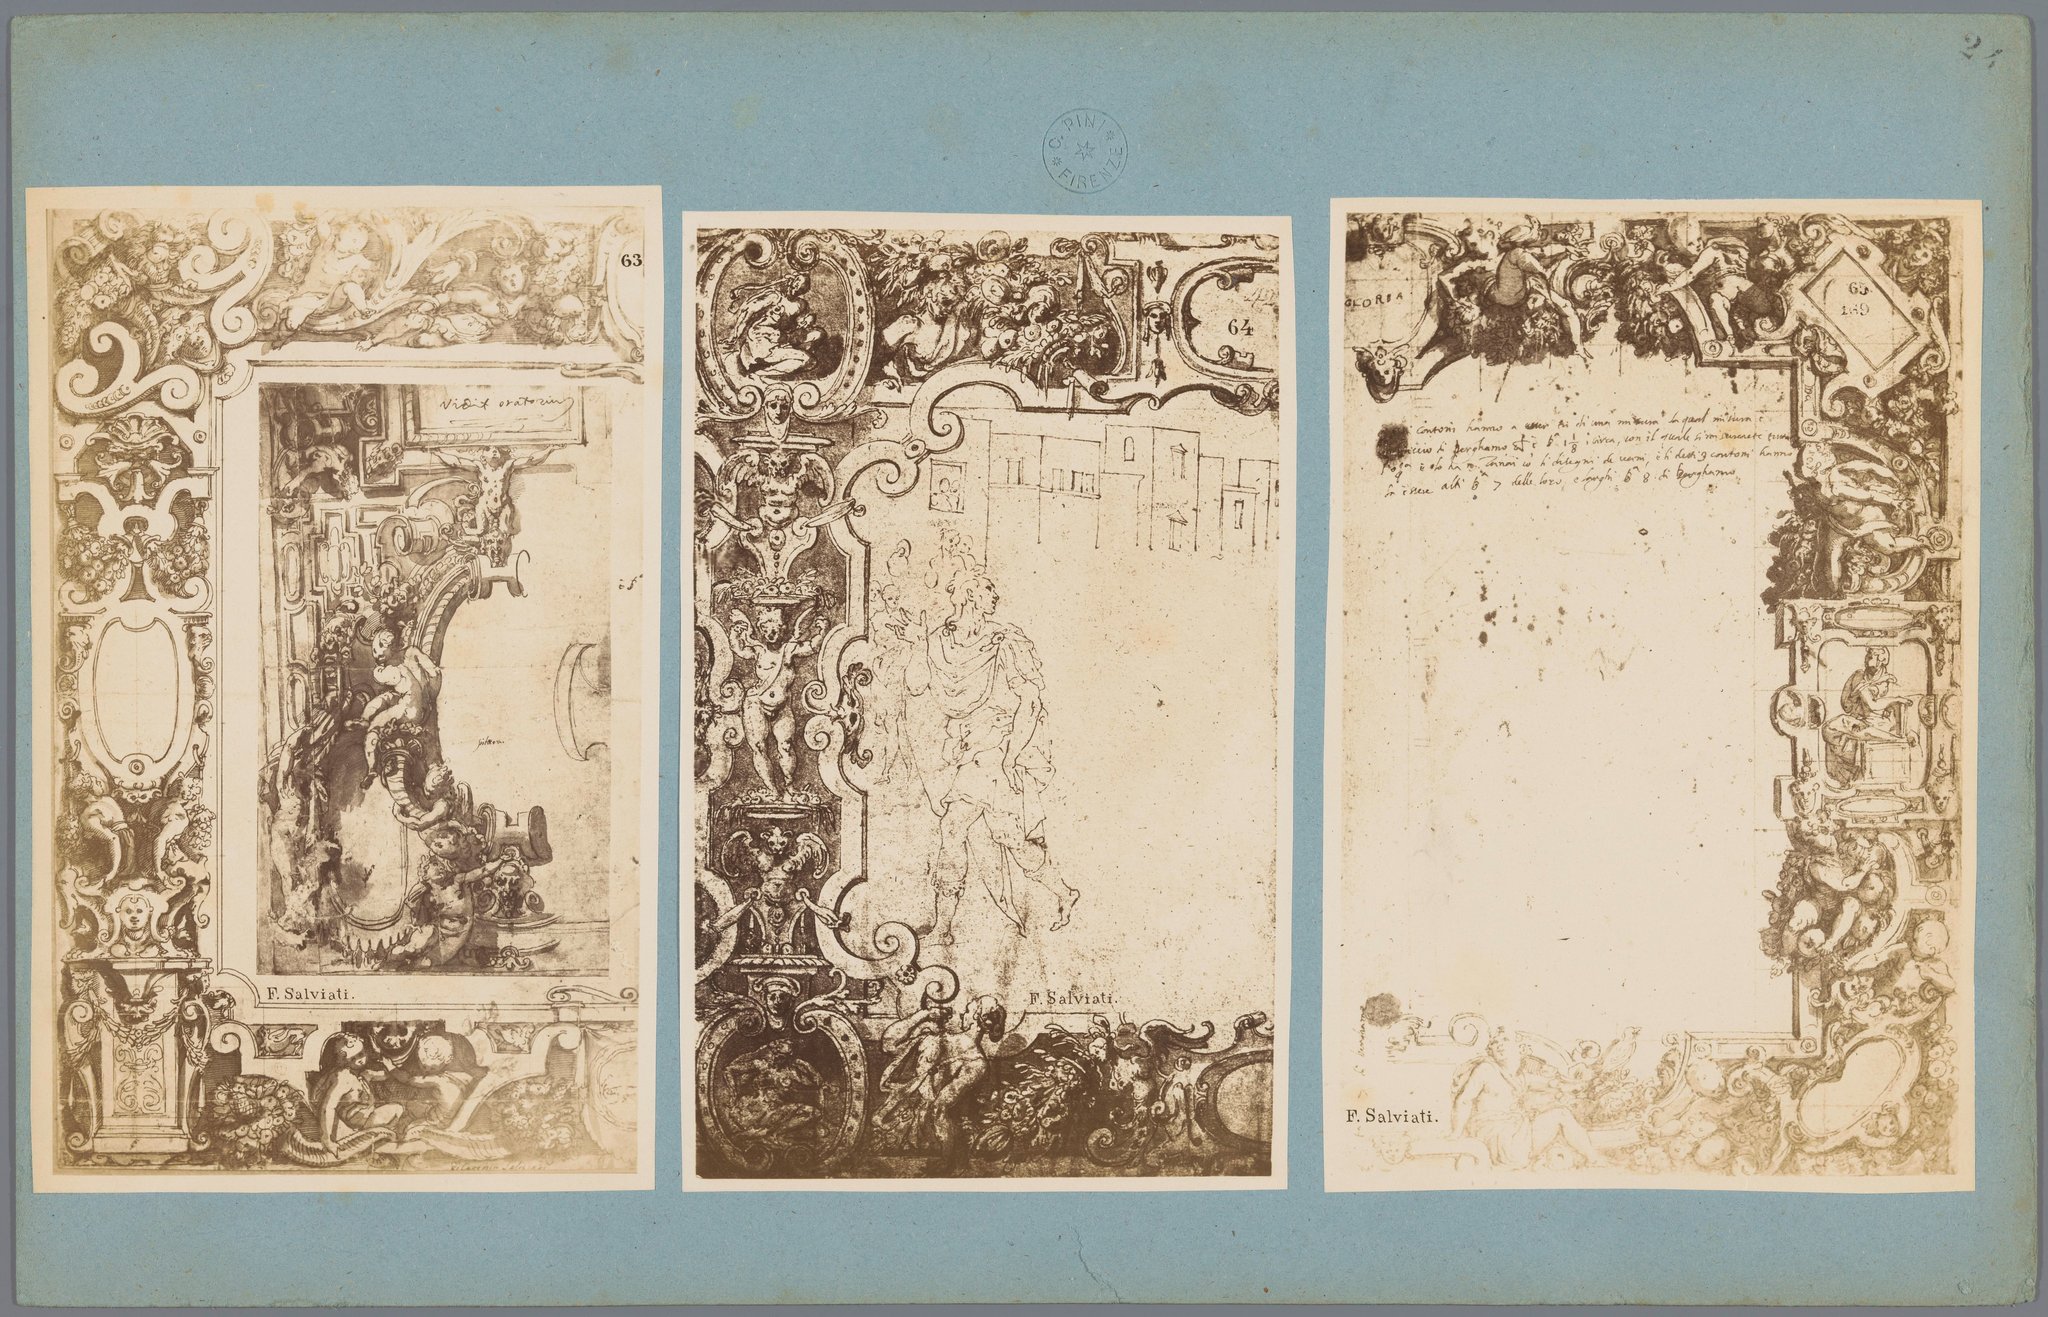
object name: photograph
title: Drie fotoreproducties van ontwerpen voor fresco's door Francesco Salviati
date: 1875-1900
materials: cardboard, photographic support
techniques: albumen print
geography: europe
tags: painting (including book-illumination, miniature-painting) (+ plaster ~ arts), angels, ornament derived from plant forms, europe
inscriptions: name: ‘C. Pini Firenze’, number: ‘24’, number: ‘64’, number: ‘169’, number: ‘63.’, collector's mark: Lugt 3937, number: ‘65.’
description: Drie (63, 64 en 65) ontwerpen voor de omlijsting van fresco's gedecoreerd met cartouches, plantmotieven en engelen.